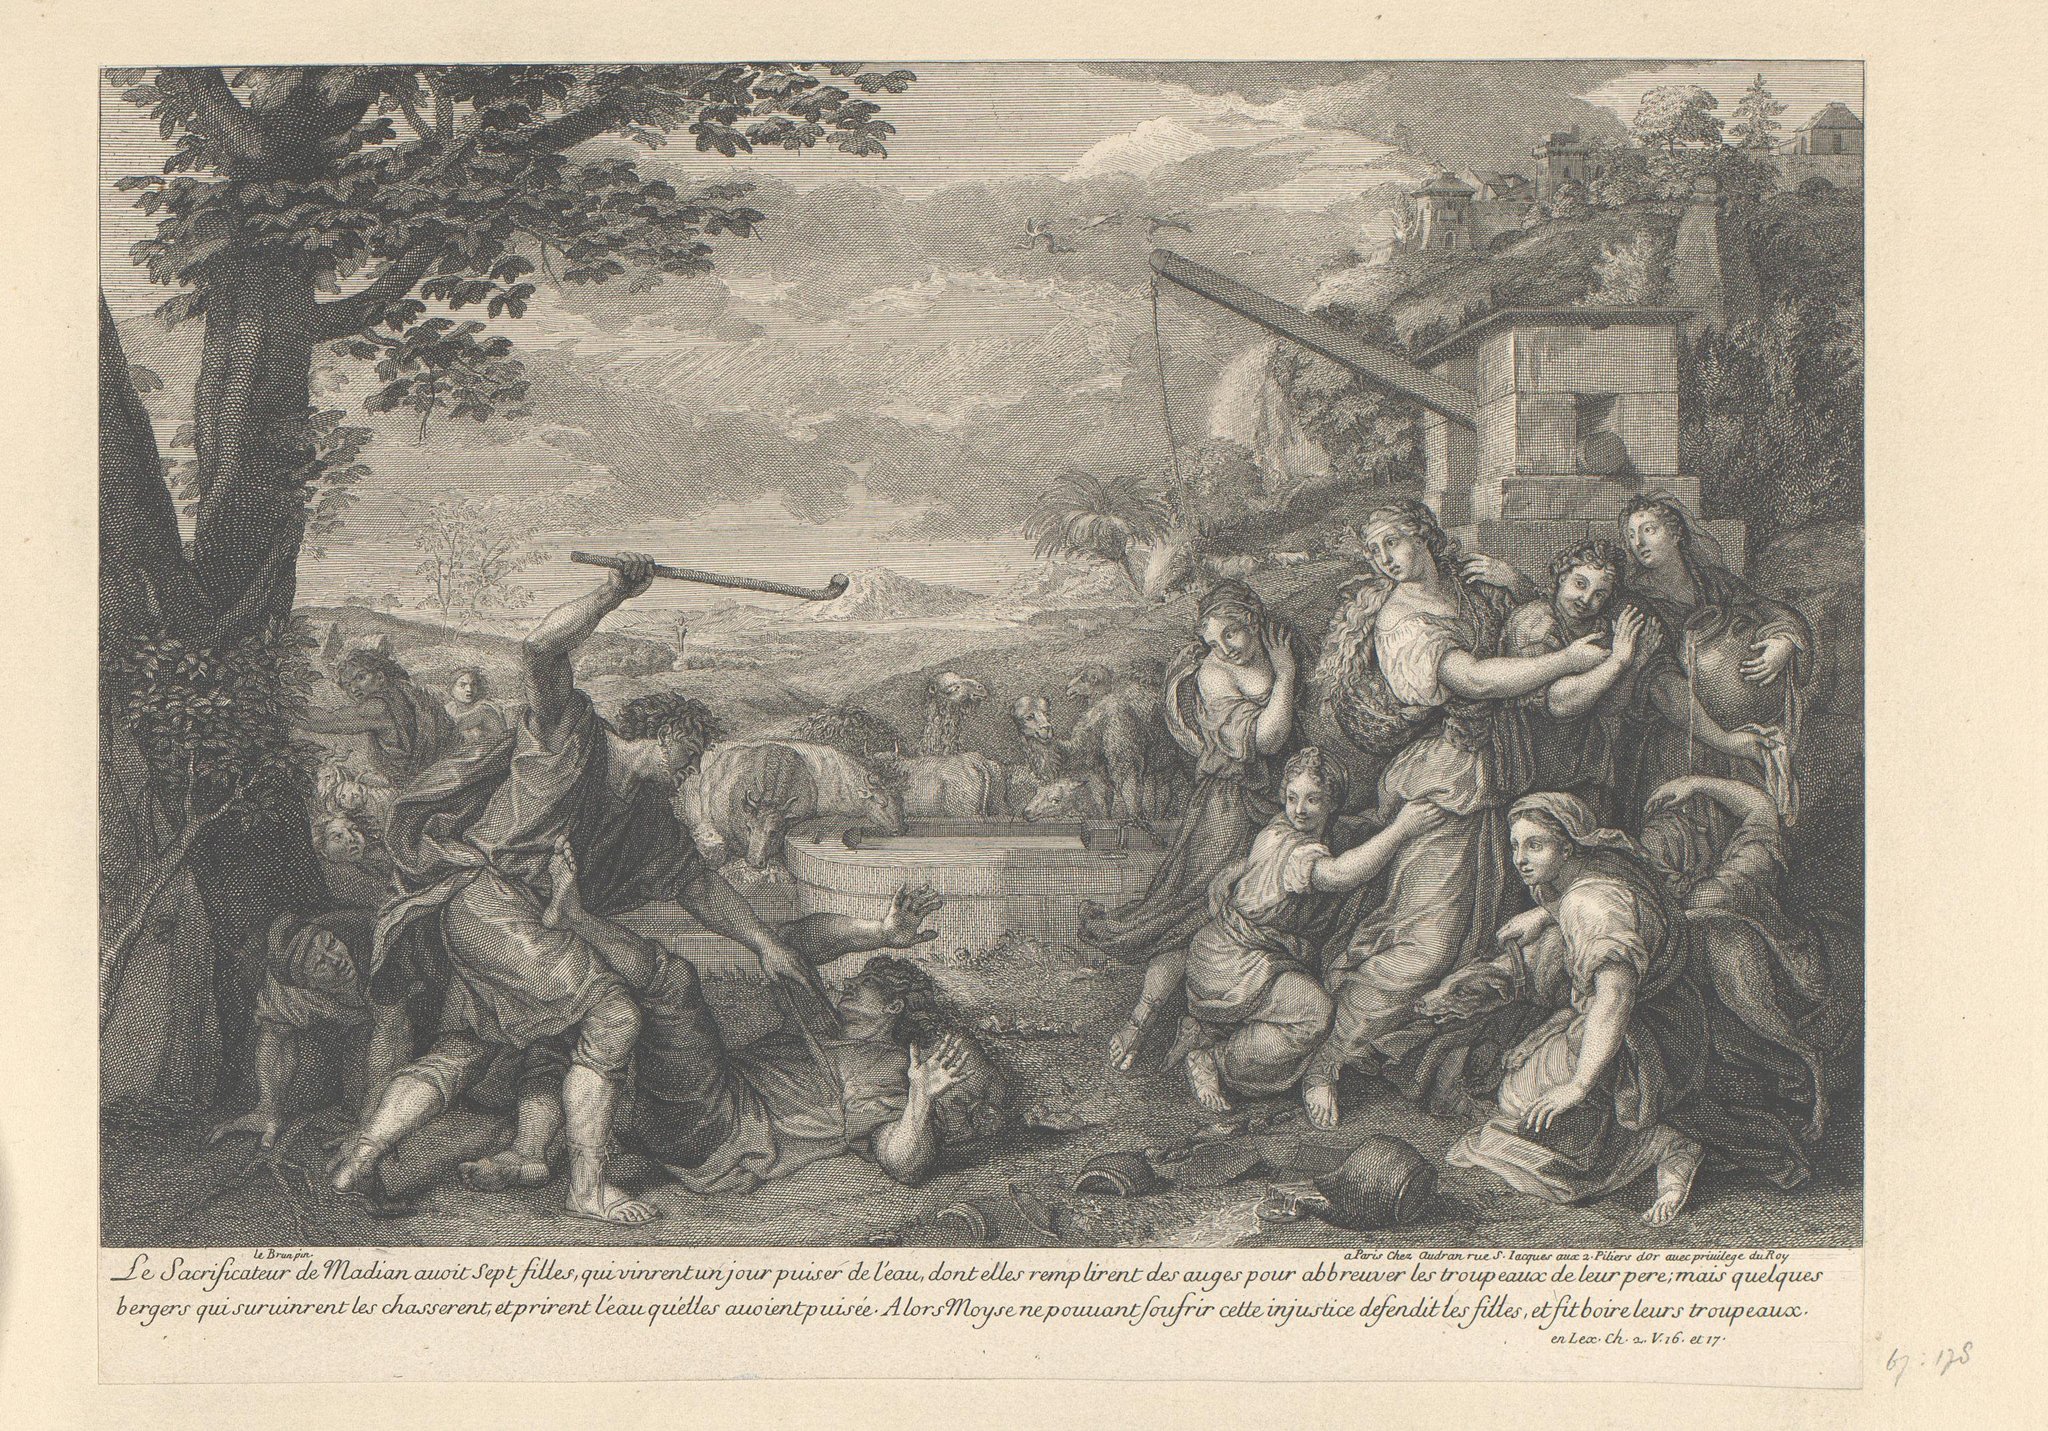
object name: print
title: Werken van Charles le Brun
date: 1686-1701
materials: paper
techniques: engraving, etching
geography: paris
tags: moses drives away the shepherds who wanted to prevent jethro's daughters from watering their father's flock, fist-fight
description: Verkleinde versie van RP-P-1967-177. Deze variant onbeschreven in de naslagwerken.